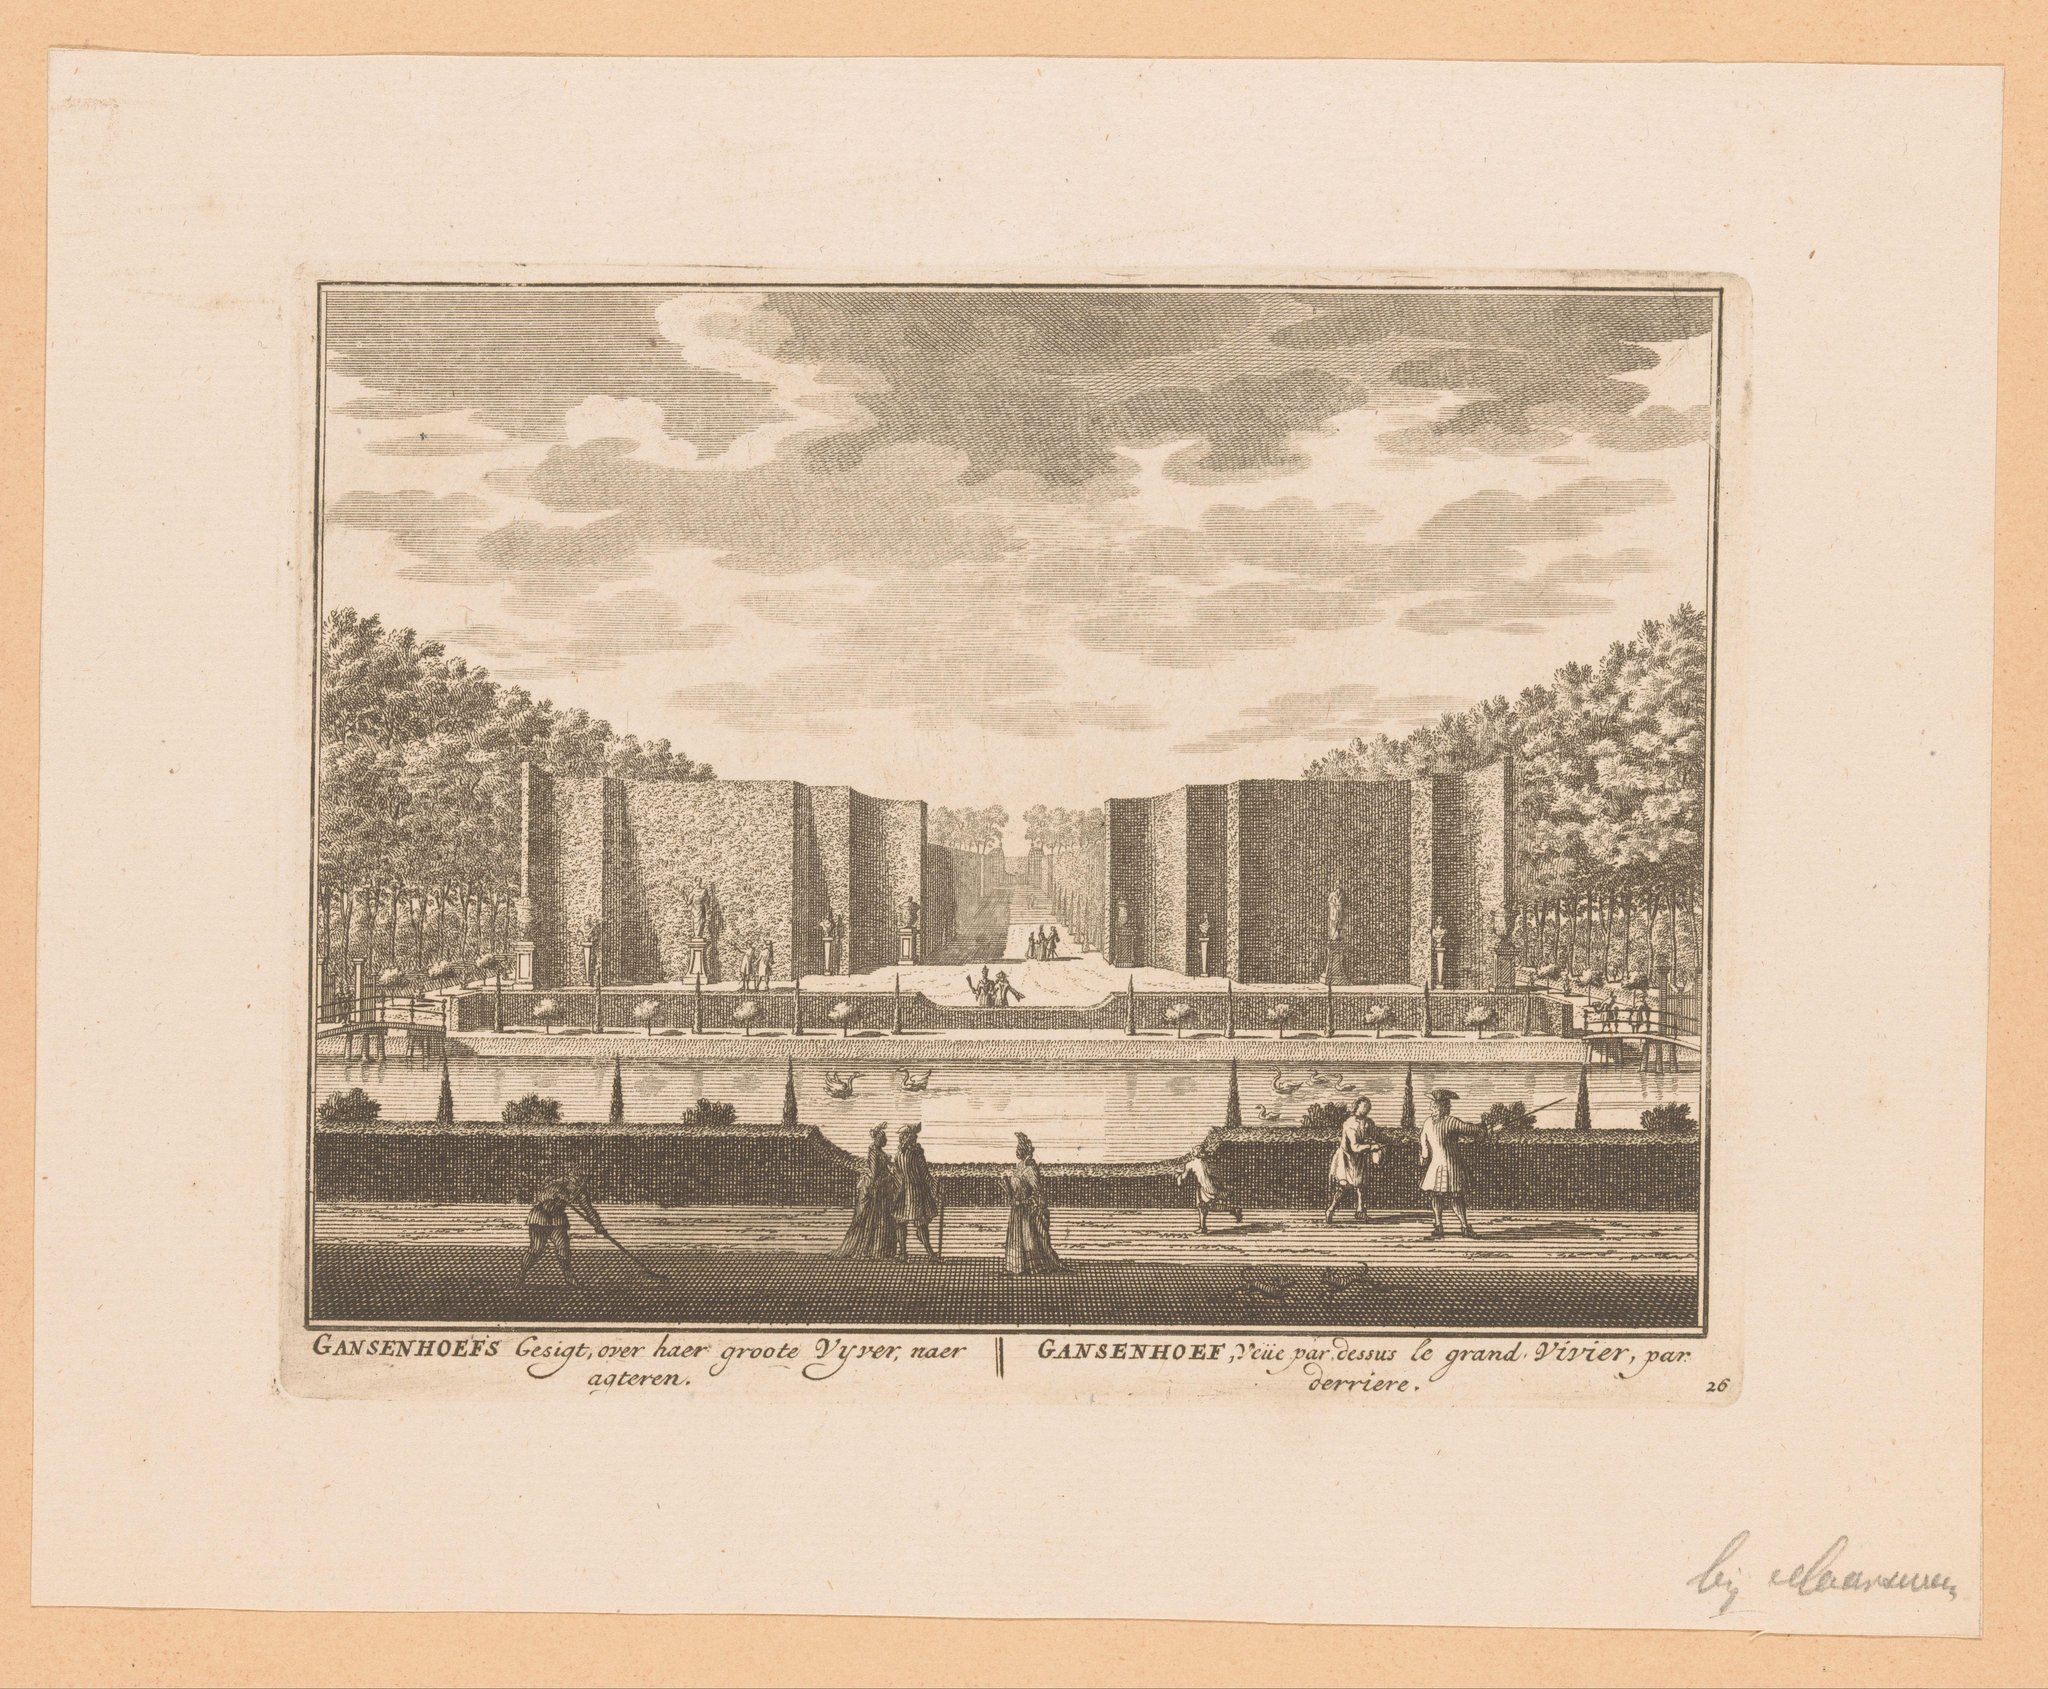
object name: print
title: Gansenhoefs gesigt, over haer groote Vyver, naer agteren / Gansenhoef, veüe par dessus le grand Vivier, par derriere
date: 1719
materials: paper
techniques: engraving, etching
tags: rural housing, e.g. country-house, villa, cottage, french or architectonic garden; formal garden, garden pond, maarssen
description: Prent uit: De zegepraalende Vecht, vertoonende verscheidene gesichten van lustplaatsen, heeren huysen en dorpen, beginnende van Uitrecht en met Muyden besluytende. Amsterdam: Wed. Nicolaes Visscher, 1719.